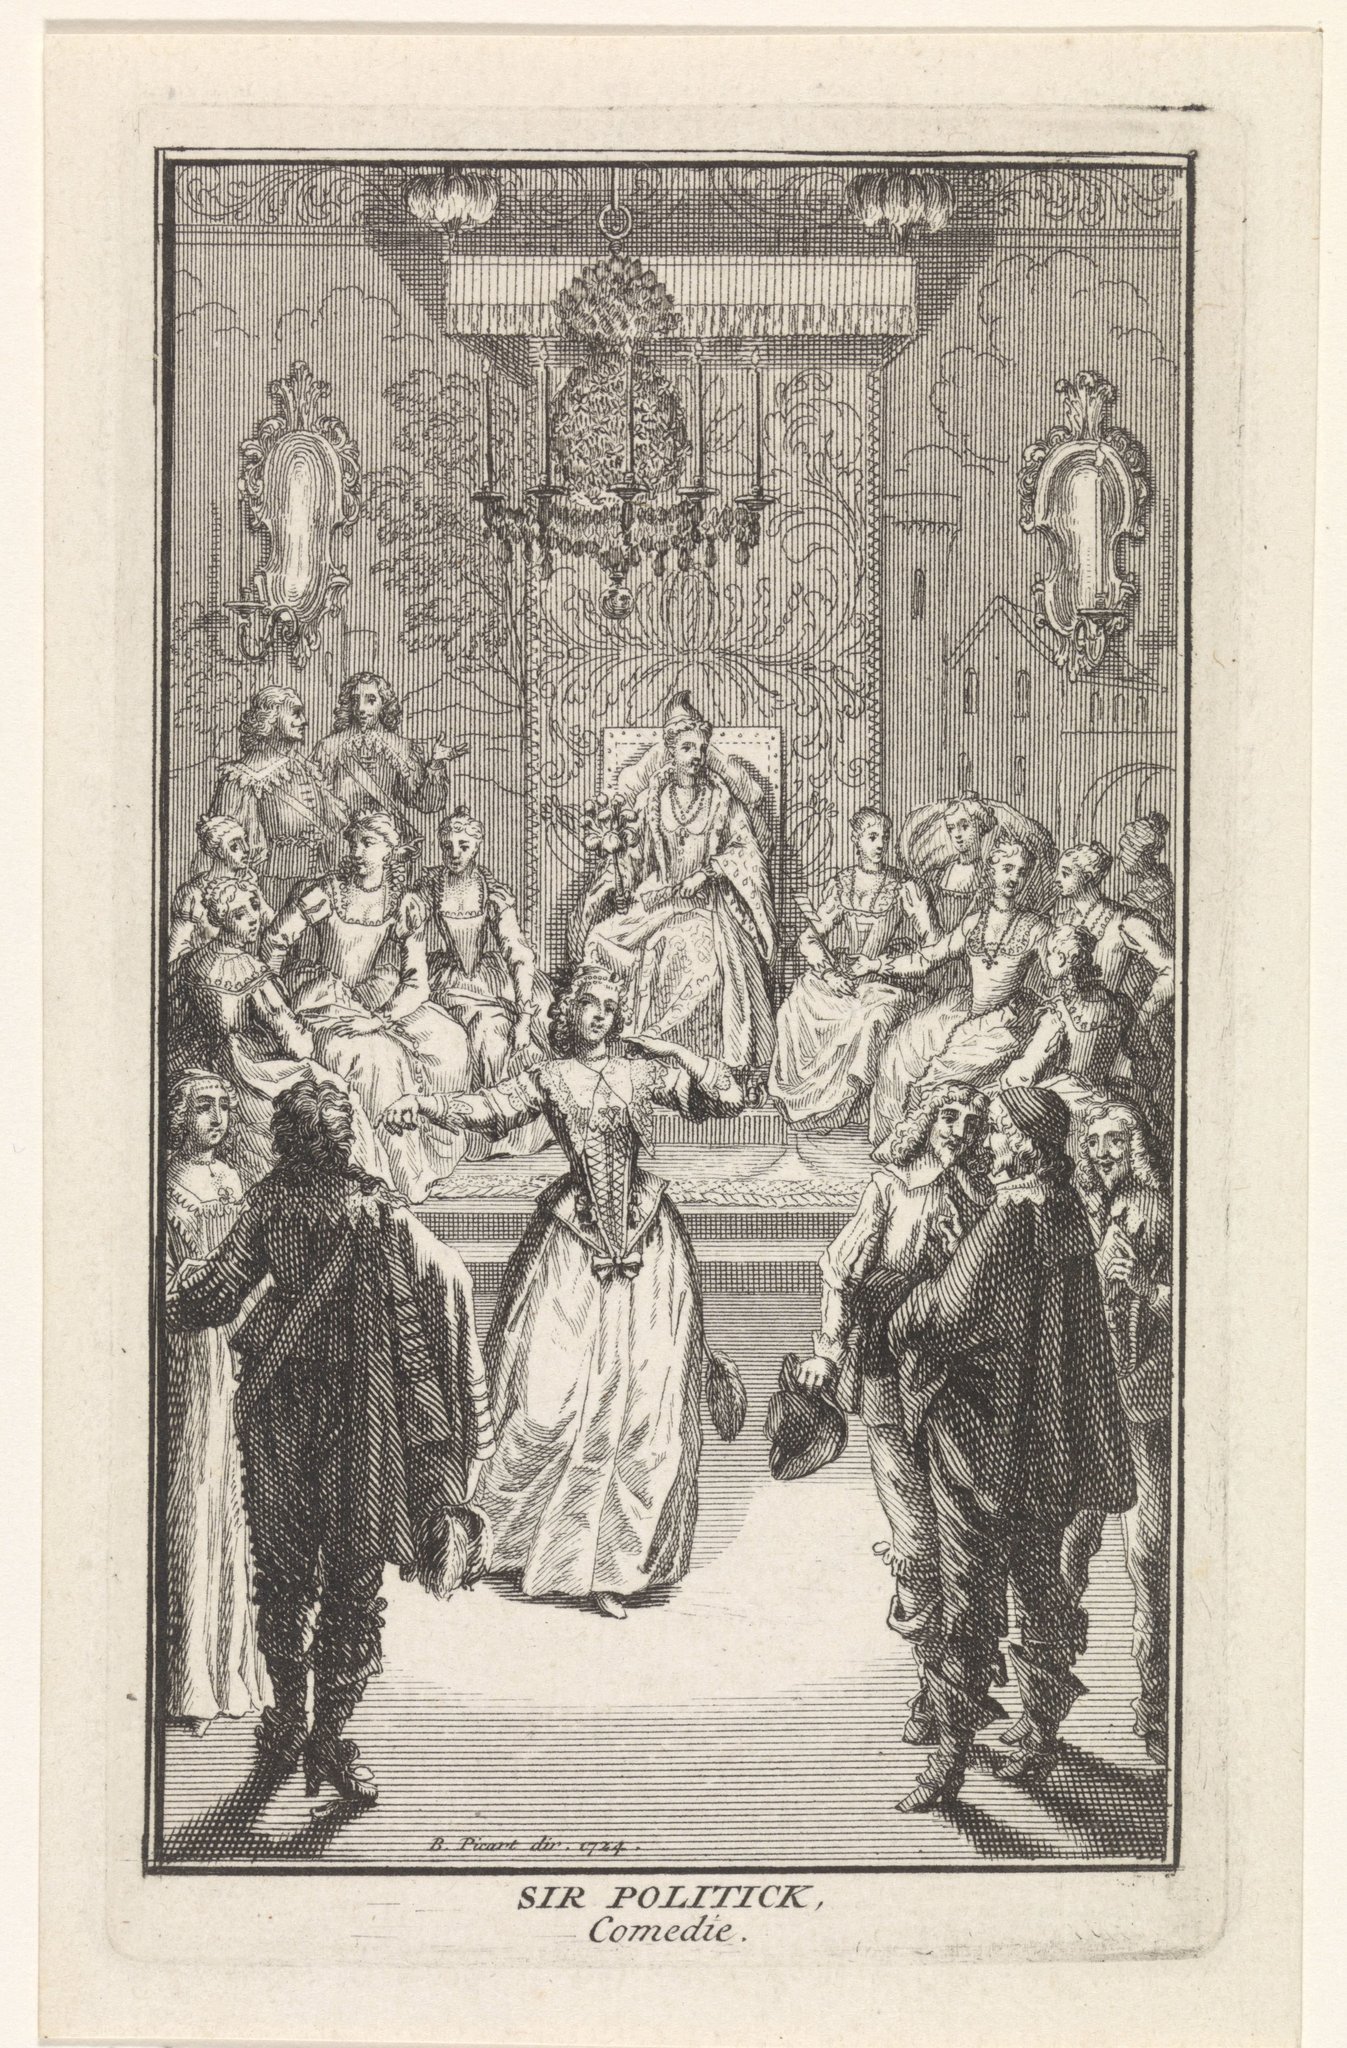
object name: print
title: Sir Politick, Comedie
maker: bernard picart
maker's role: draughtsman, print maker, publisher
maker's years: 1673-1733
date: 1724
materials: paper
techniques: engraving, etching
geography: amsterdam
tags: courtesan, hetaera, loose company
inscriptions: collector's mark: Lugt 240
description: Prent ook gebruikt als illustratie in: Charles de Marguetel de Saint-Denis de Saint-Evremond. Oeuvres. Amsterdam: Johannes Covens en Cornelis Mortier, 1726.